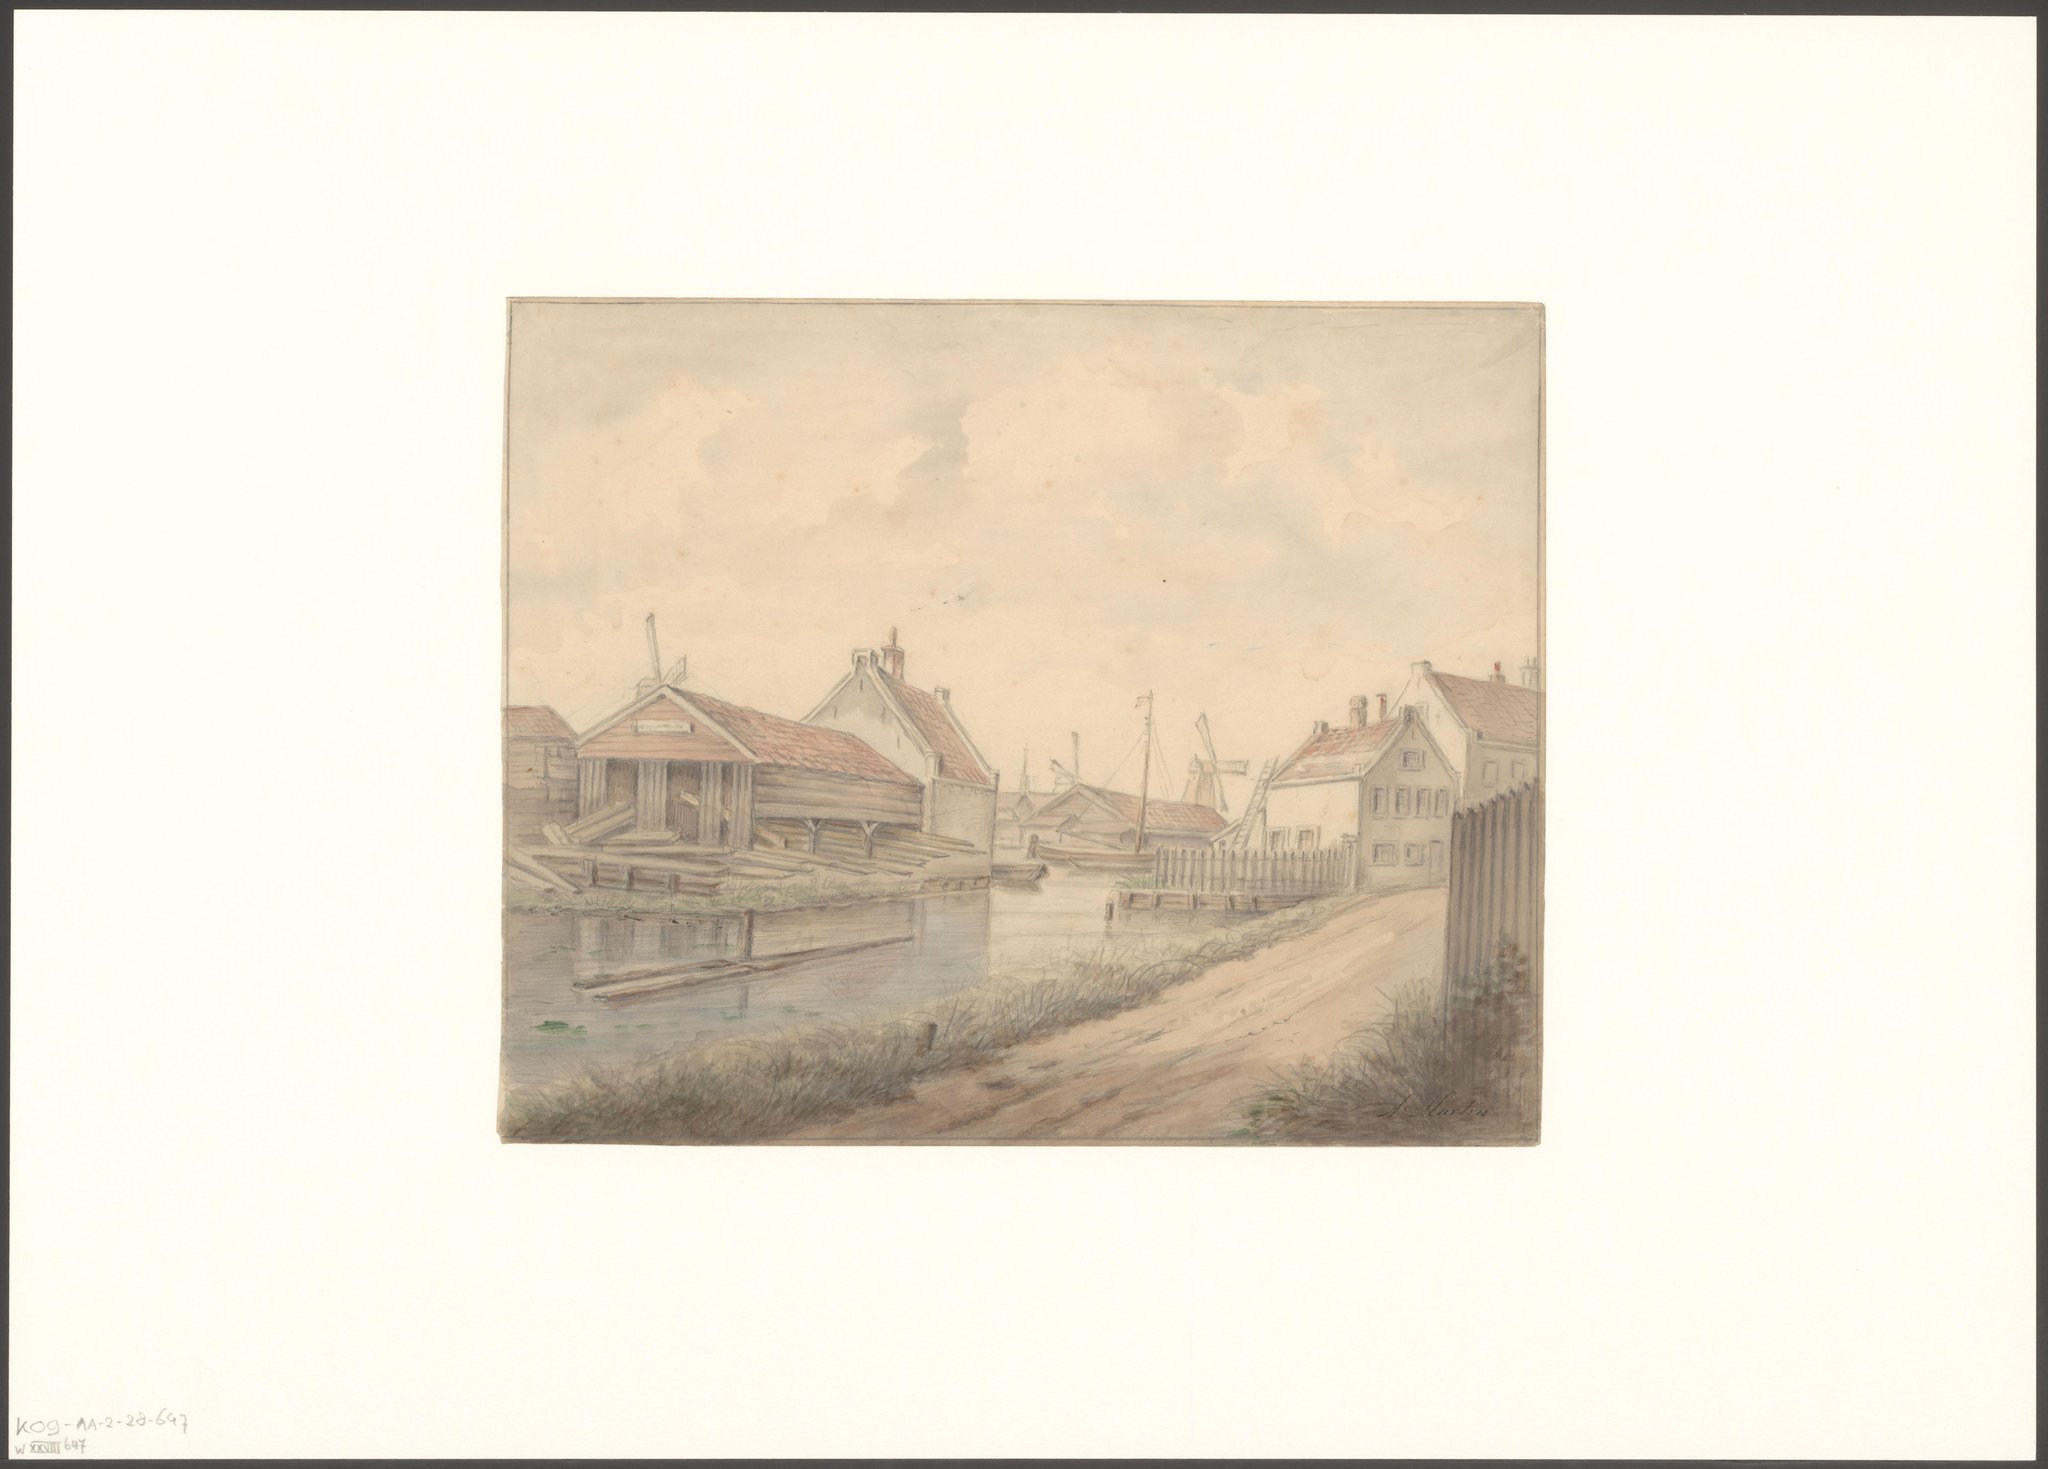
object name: drawing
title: Gezicht op enkele molens vanaf de Achterweg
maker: albert martin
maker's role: draughtsman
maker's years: 1827-1900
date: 1837-1900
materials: paper, pencil, watercolor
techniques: brush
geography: amsterdam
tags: city-view in general; 'veduta', canal, road, path, windmill in landscape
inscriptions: signature: ‘A.Martin’, inscription: ‘de Eenhoorn / Achterweg naar de Molen het Luipaard’, collector's mark: Lugt 800a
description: Tekening binnen de Atlas Van Eck ingedeeld op wijknummer 28.